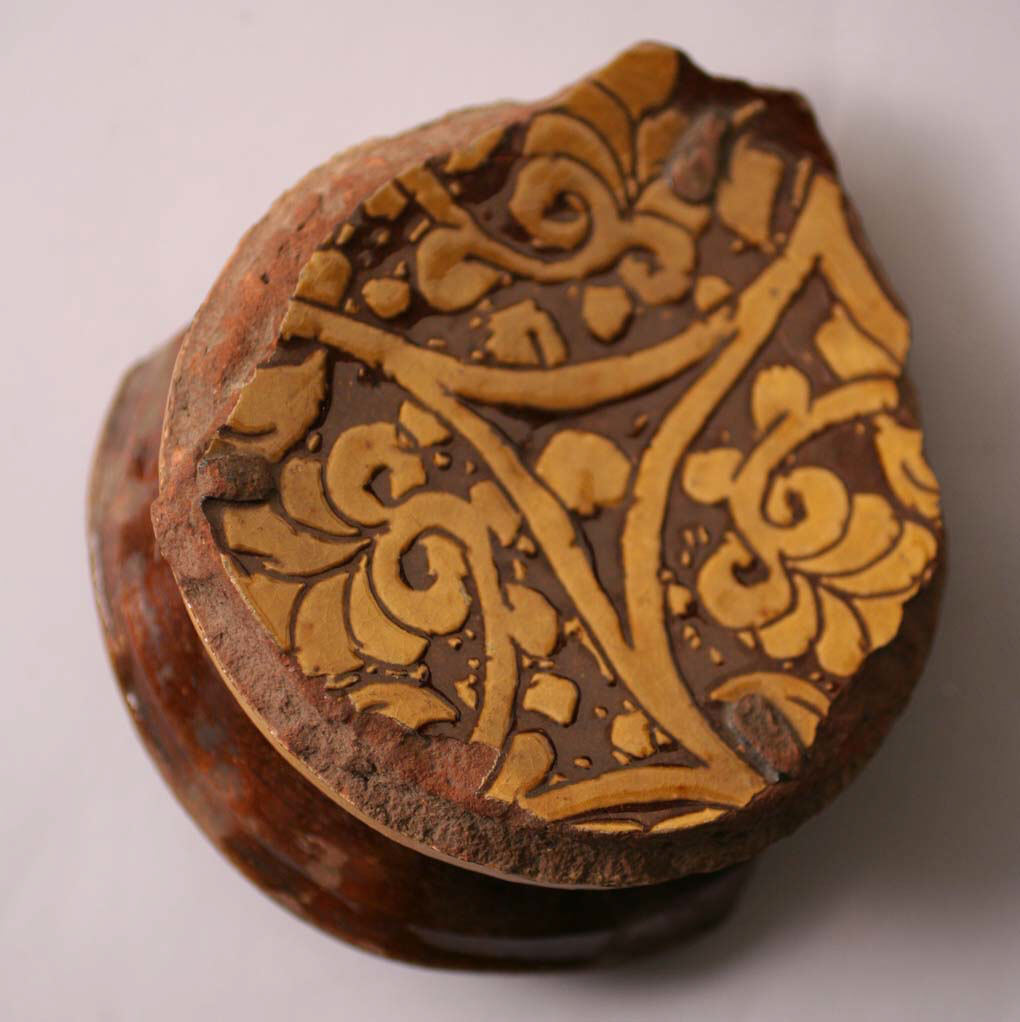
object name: fragment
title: Fragment of a Bowl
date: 1301-1500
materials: earthenware, glaze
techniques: coloring, incising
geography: egypt